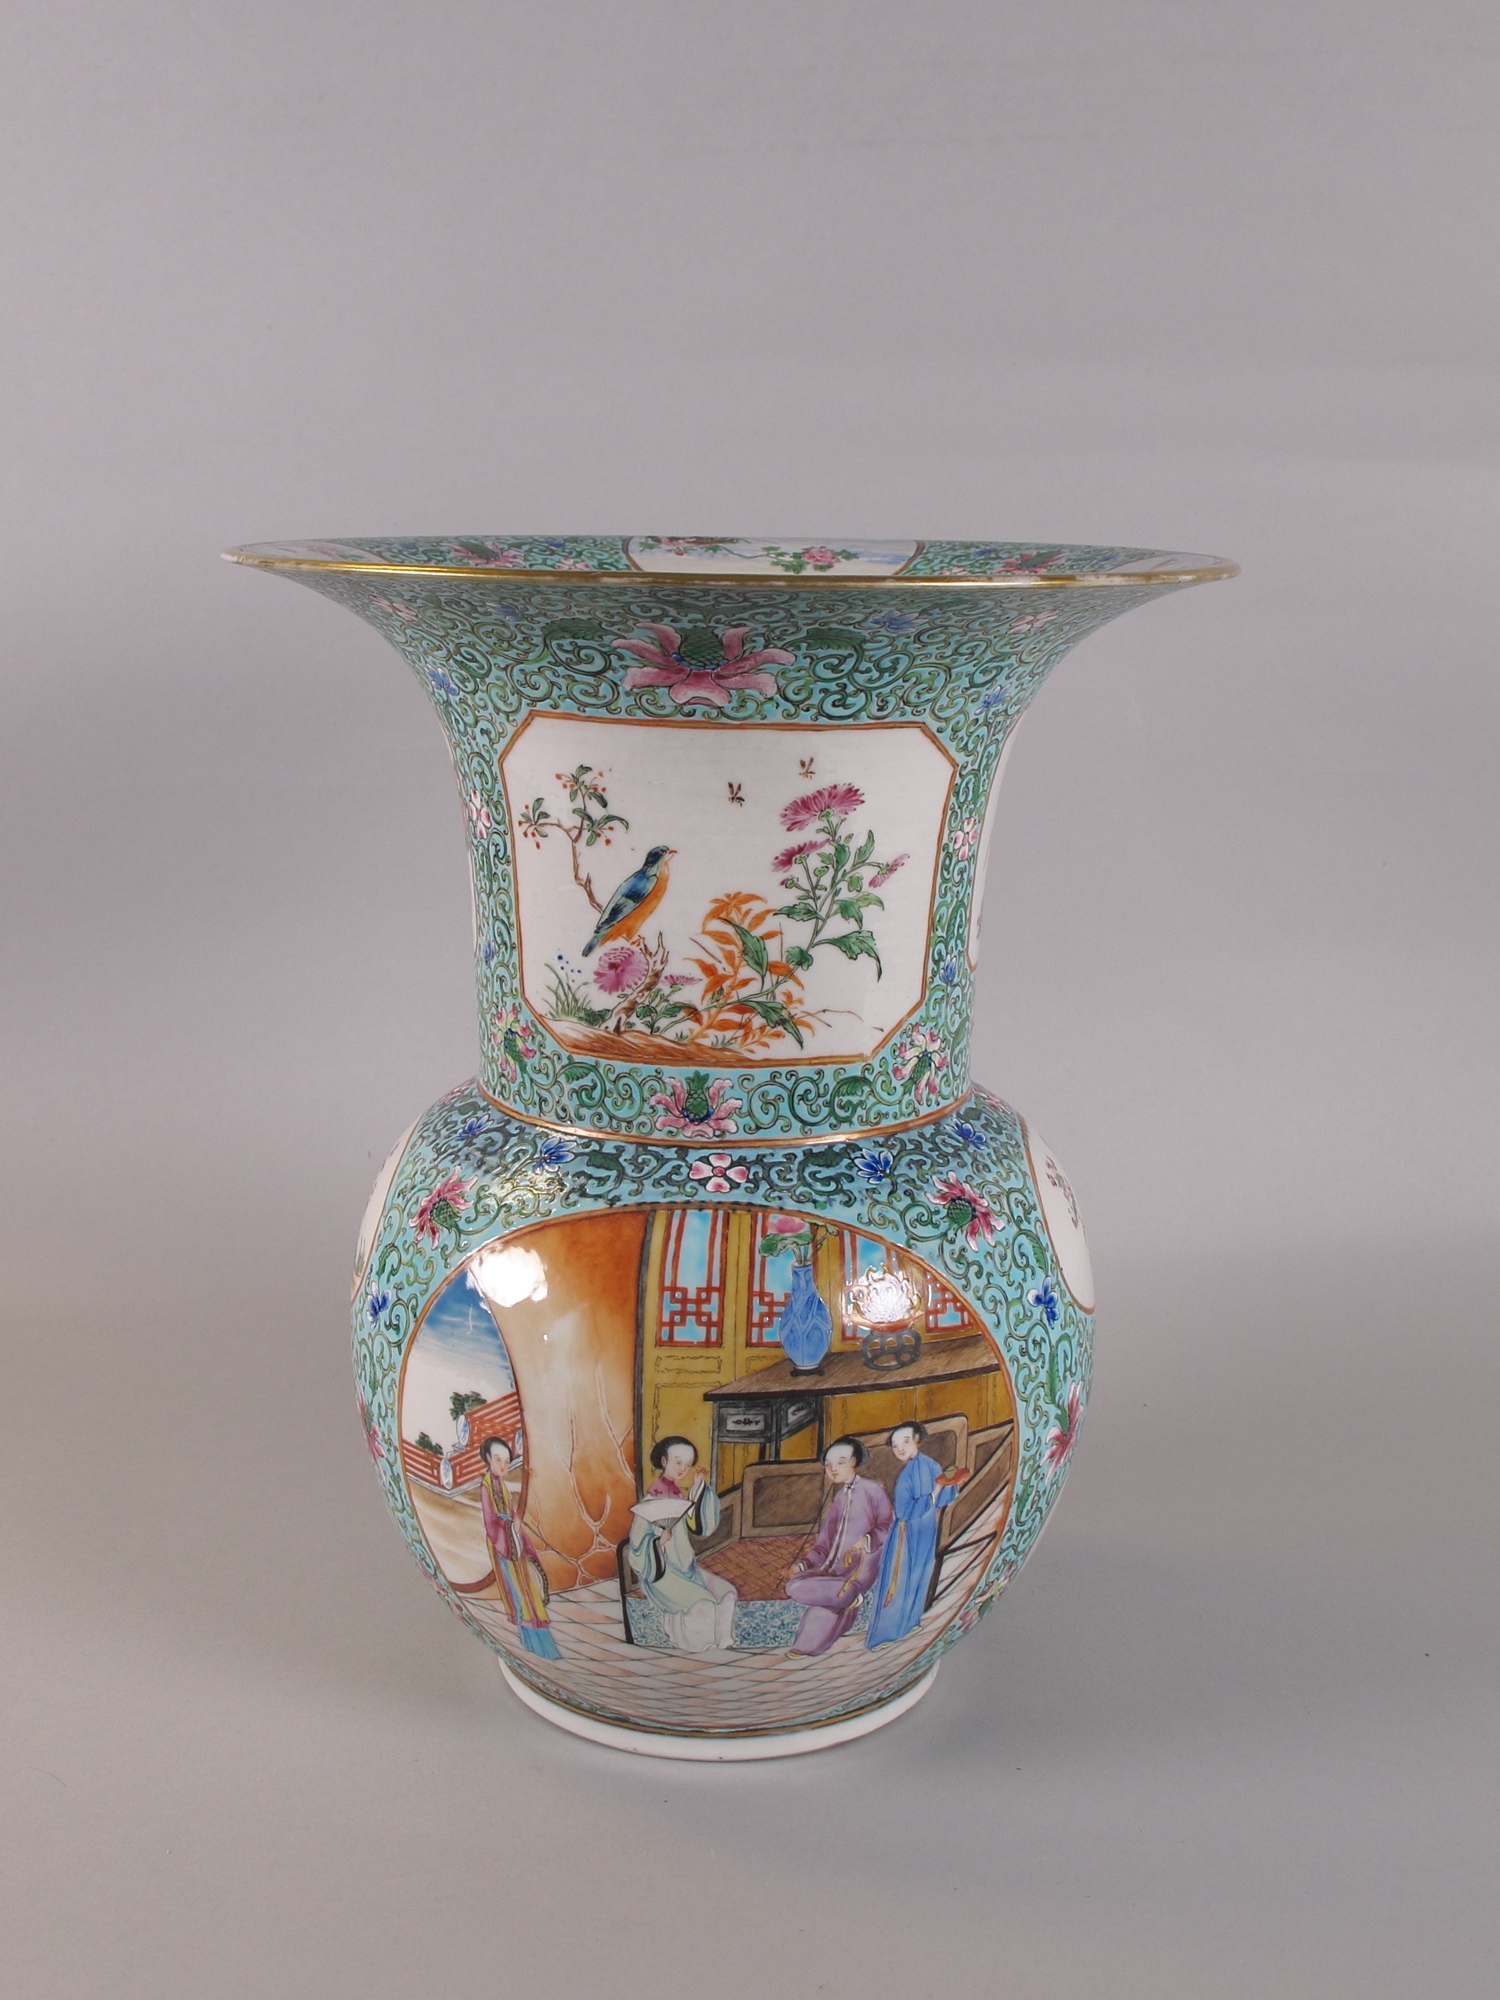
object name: vase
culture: chinese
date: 1801-1850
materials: enamel, porcelain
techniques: overglaze, painting, polychrome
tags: human figures,birds,flowers